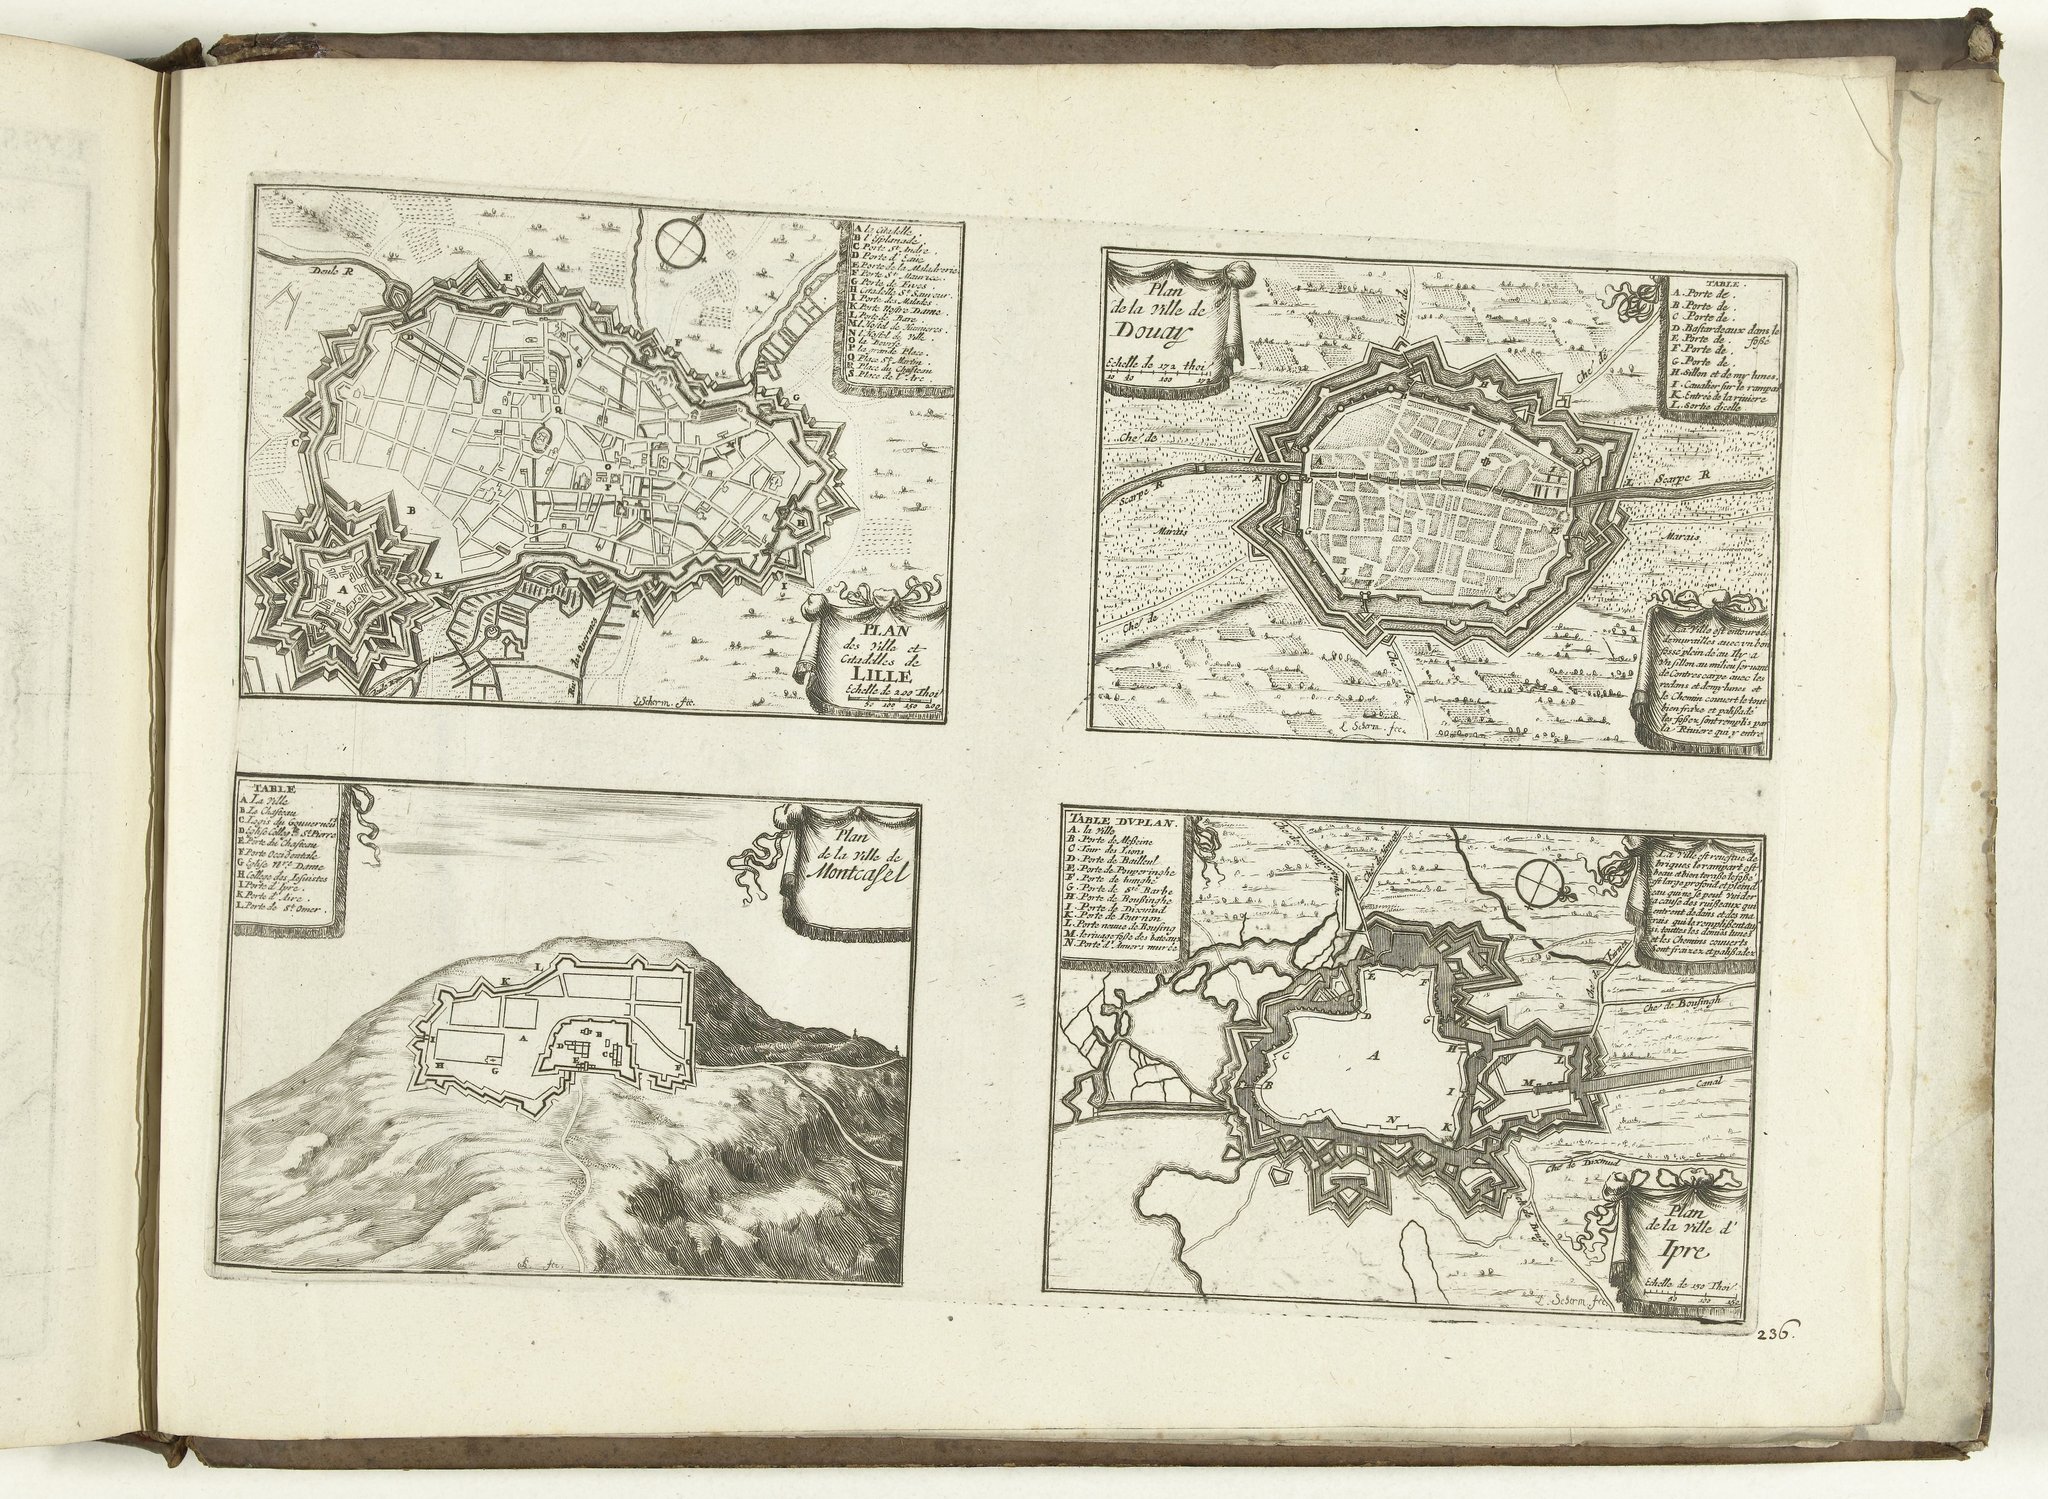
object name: print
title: Lille / Douay / Montcasel / Ipre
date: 1726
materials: paper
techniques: etching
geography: northern netherlands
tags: fortress, maps of cities, lille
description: Blad met vier plattegronden van de versterkingen om de steden Lille, Douai, Montcassel (?) en Yperen. Plaat nr. 236 in deel X van het prentwerk: Les Forces de l'Europe, Asie, Afrique et Amerique ... Comme aussi les Cartes des Côtes de France et d'Espagne uit 1726, dit eerste deel met 238 met de hand genummerde platen van vermaarde sterke steden en vestingen in het kader van de Spaanse Successieoorlog 1701-1713. Voor het merendeel zijn deze platen gekopieerd naar de anonieme Franse platen van vermaarde sterke steden en vestingen: in Les forces de l'Europe en in: Le theatre de la guerre, dans les Pays-Bas, beide oorspronkelijk uitgegeven door Nicolas de Fer te Parijs (1693-1697) in het kader van de Negenjarige Oorlog. Titels en opschriften in het Frans.